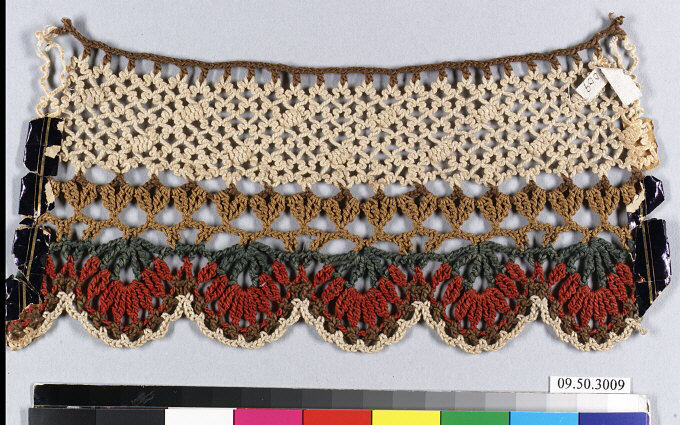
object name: piece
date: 1801-1900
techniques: crochet